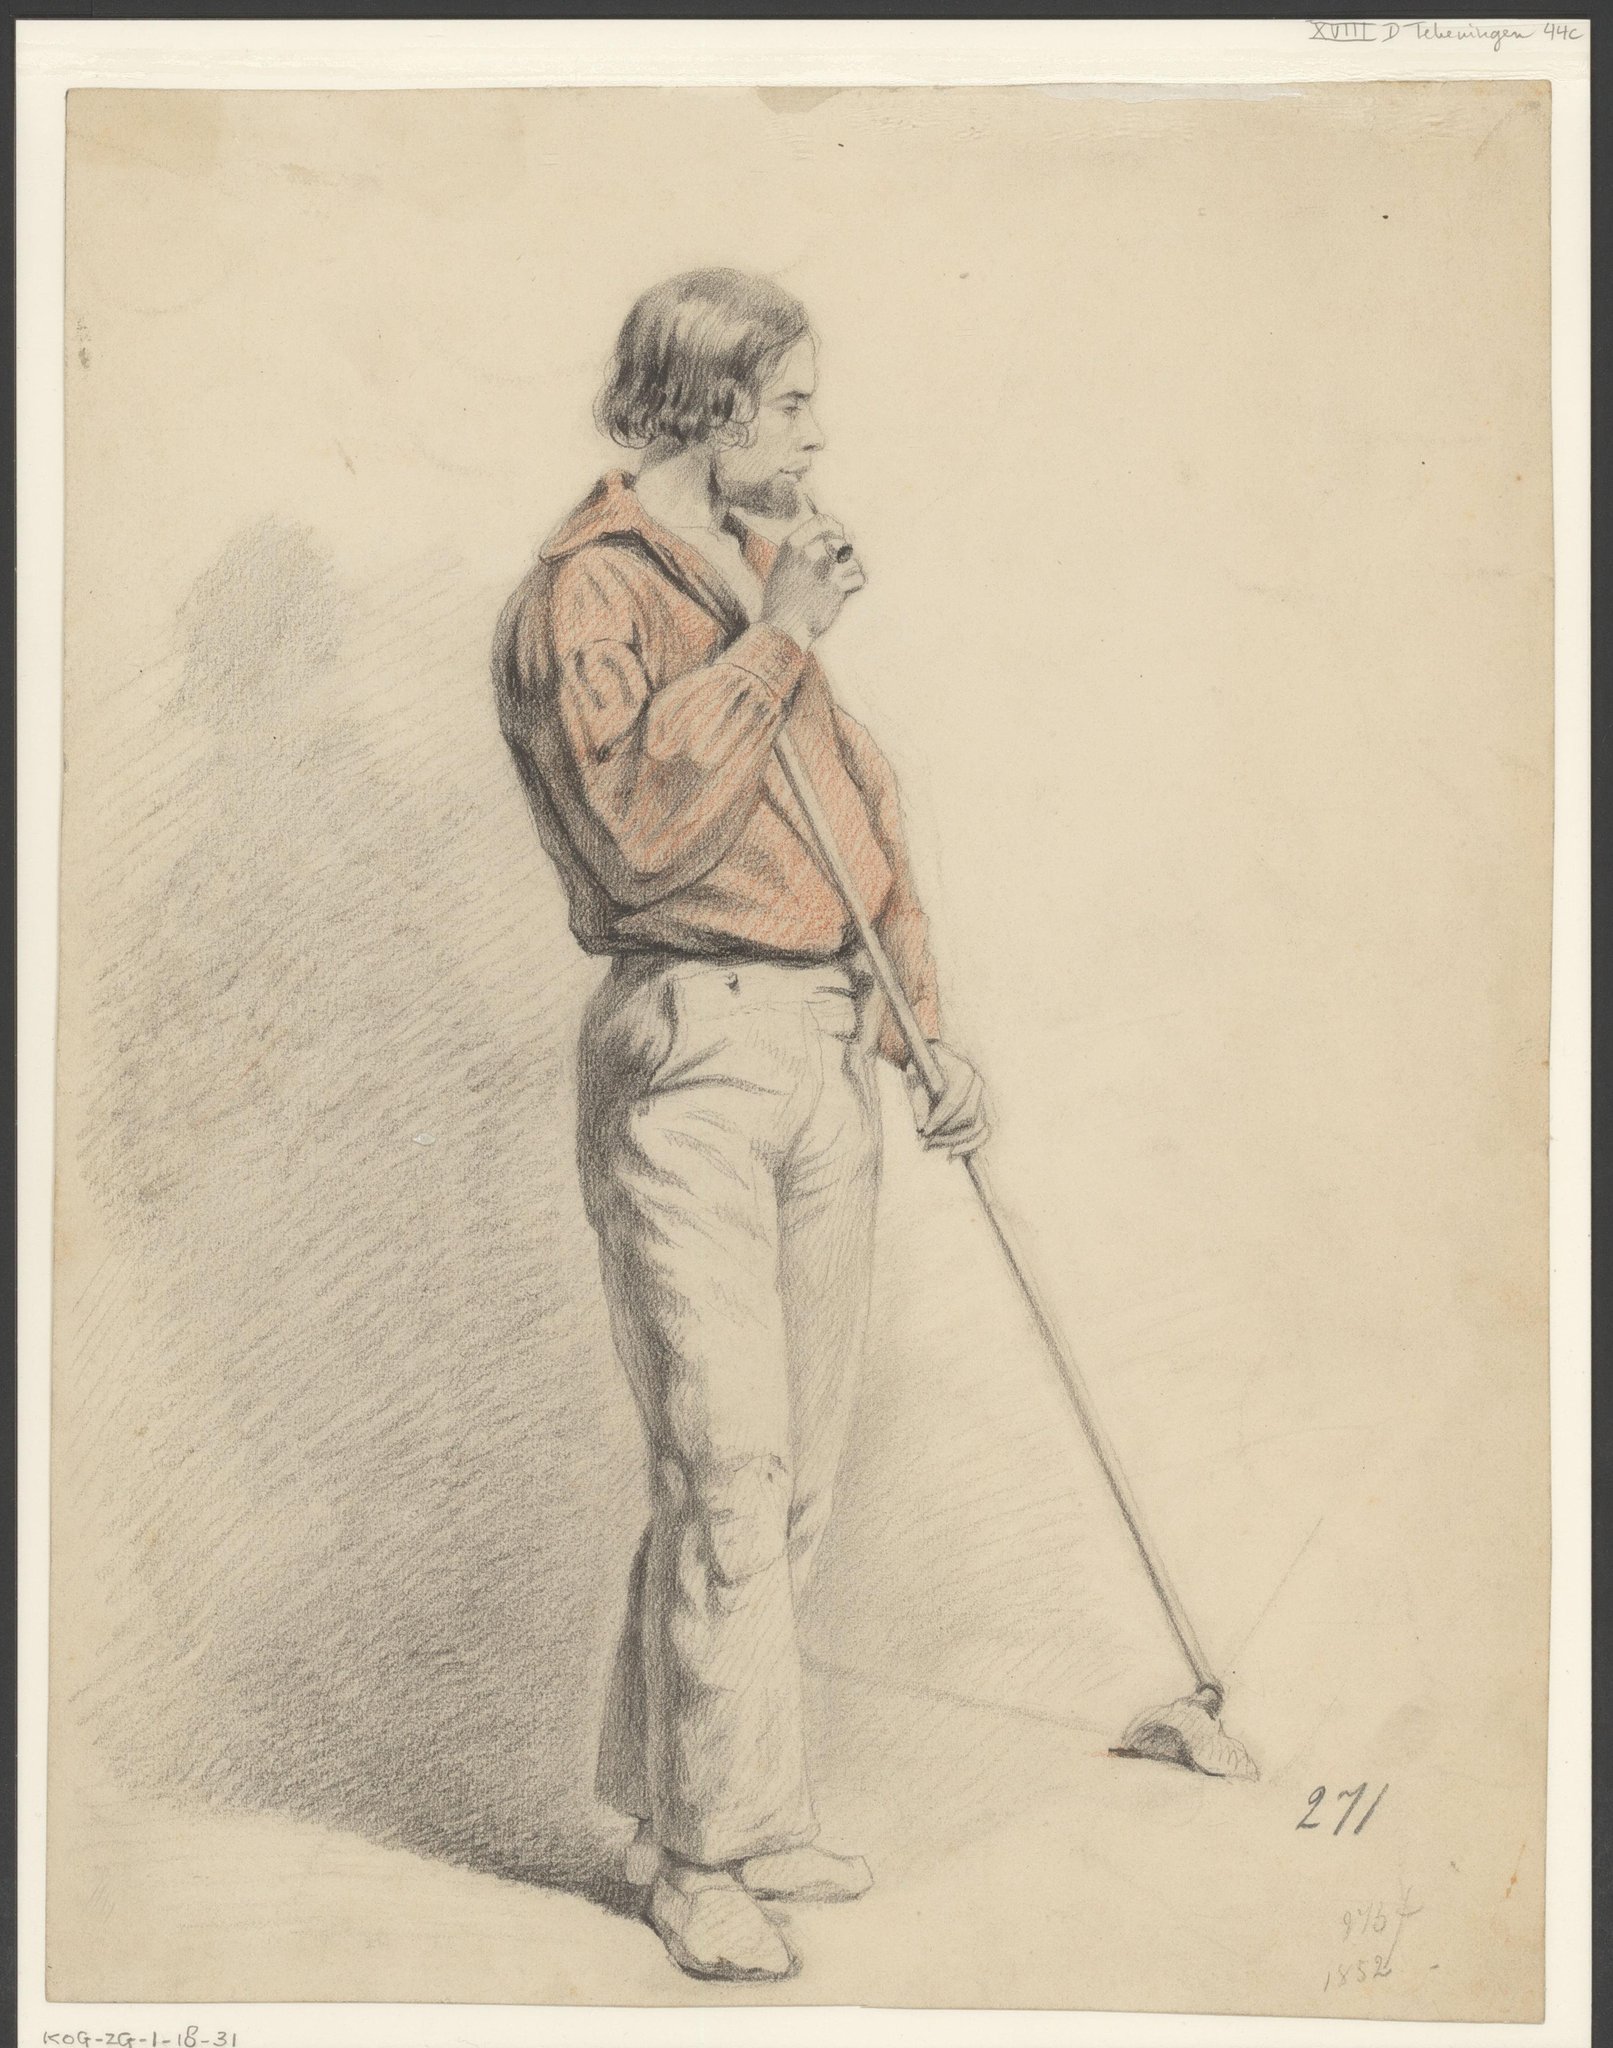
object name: drawing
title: Staande man met pijp en dweil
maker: hillebrand dirk loeff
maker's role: painter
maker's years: 1774-1845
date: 1784-1845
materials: chalk, paper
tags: standing figure, pipe ~ tobacco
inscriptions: stamp, collector's mark: Lugt 1641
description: Onderwerpsrubrieken binnen de Atlas Zeden en Gewoonten: Schoone kunsten, Schilderkunst, Tekeningen.